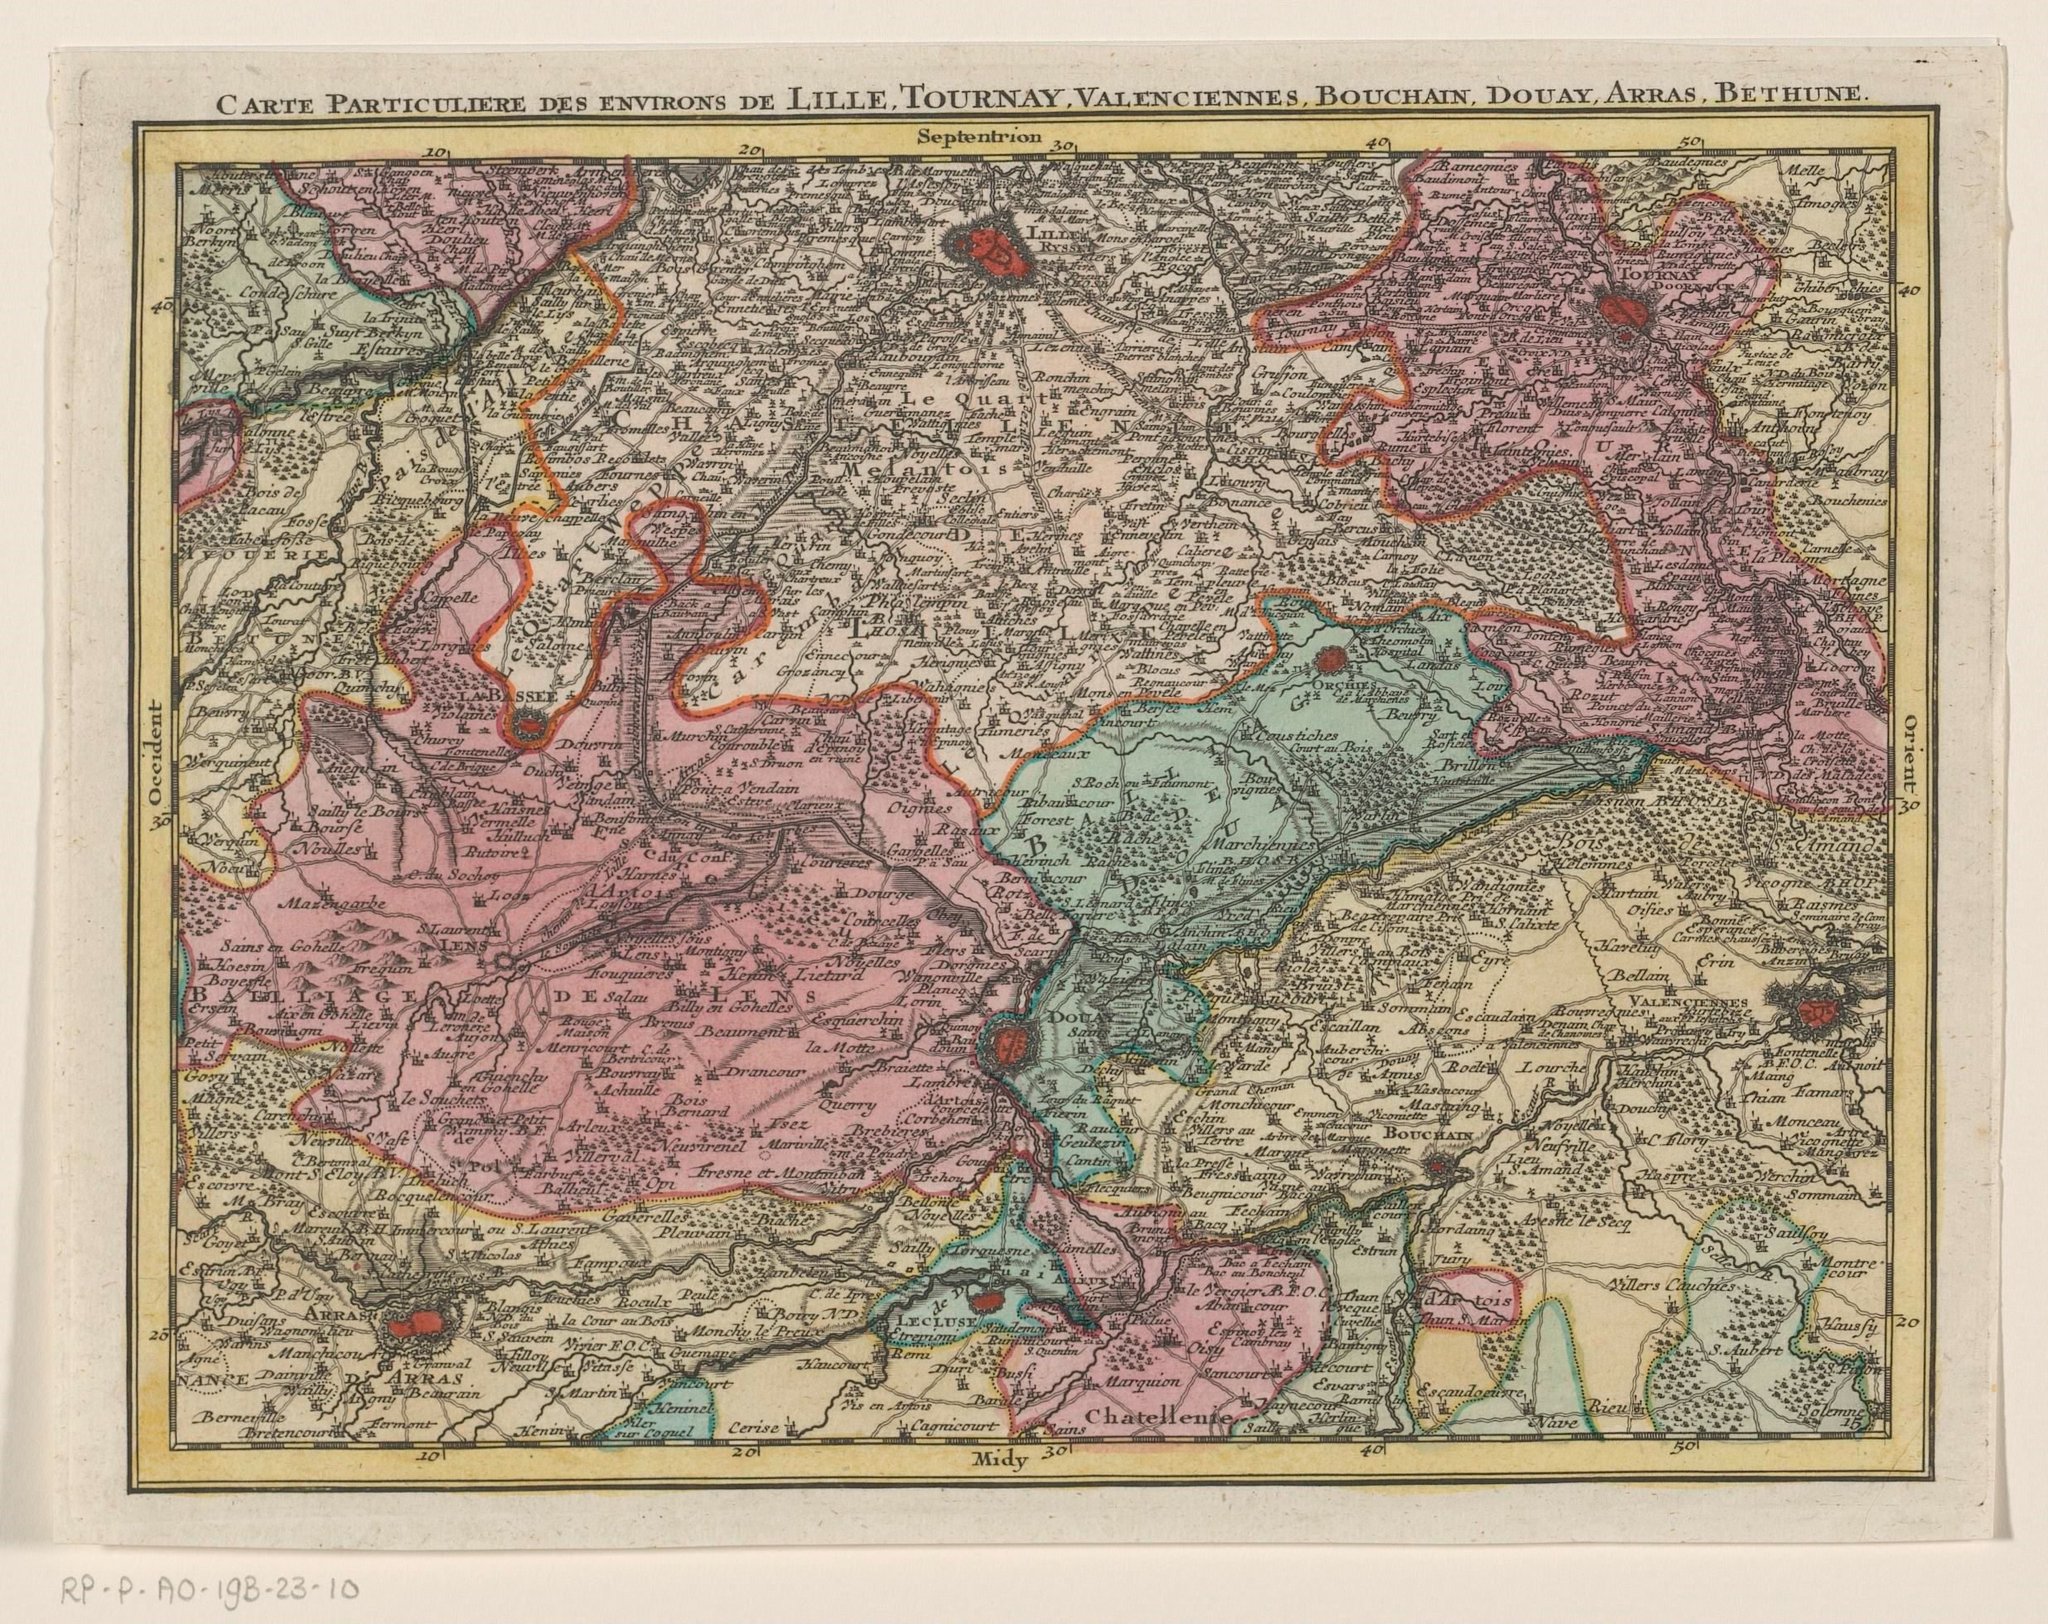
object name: print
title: Deel van een kaart van de Oostenrijkse Nederlanden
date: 1737-1757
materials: paper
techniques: engraving, hand coloring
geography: augsburg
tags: maps of separate countries or regions, southern netherlands, belgium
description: Deze kaart is onderdeel van een wandkaart van de Oostenrijkse Nederlanden, bestaande uit vier rijen van zes delen. De delen van de kaart zijn rechtsonder genummerd, beginnend bij het deel linksboven (1) tot het deel rechtsonder (24).